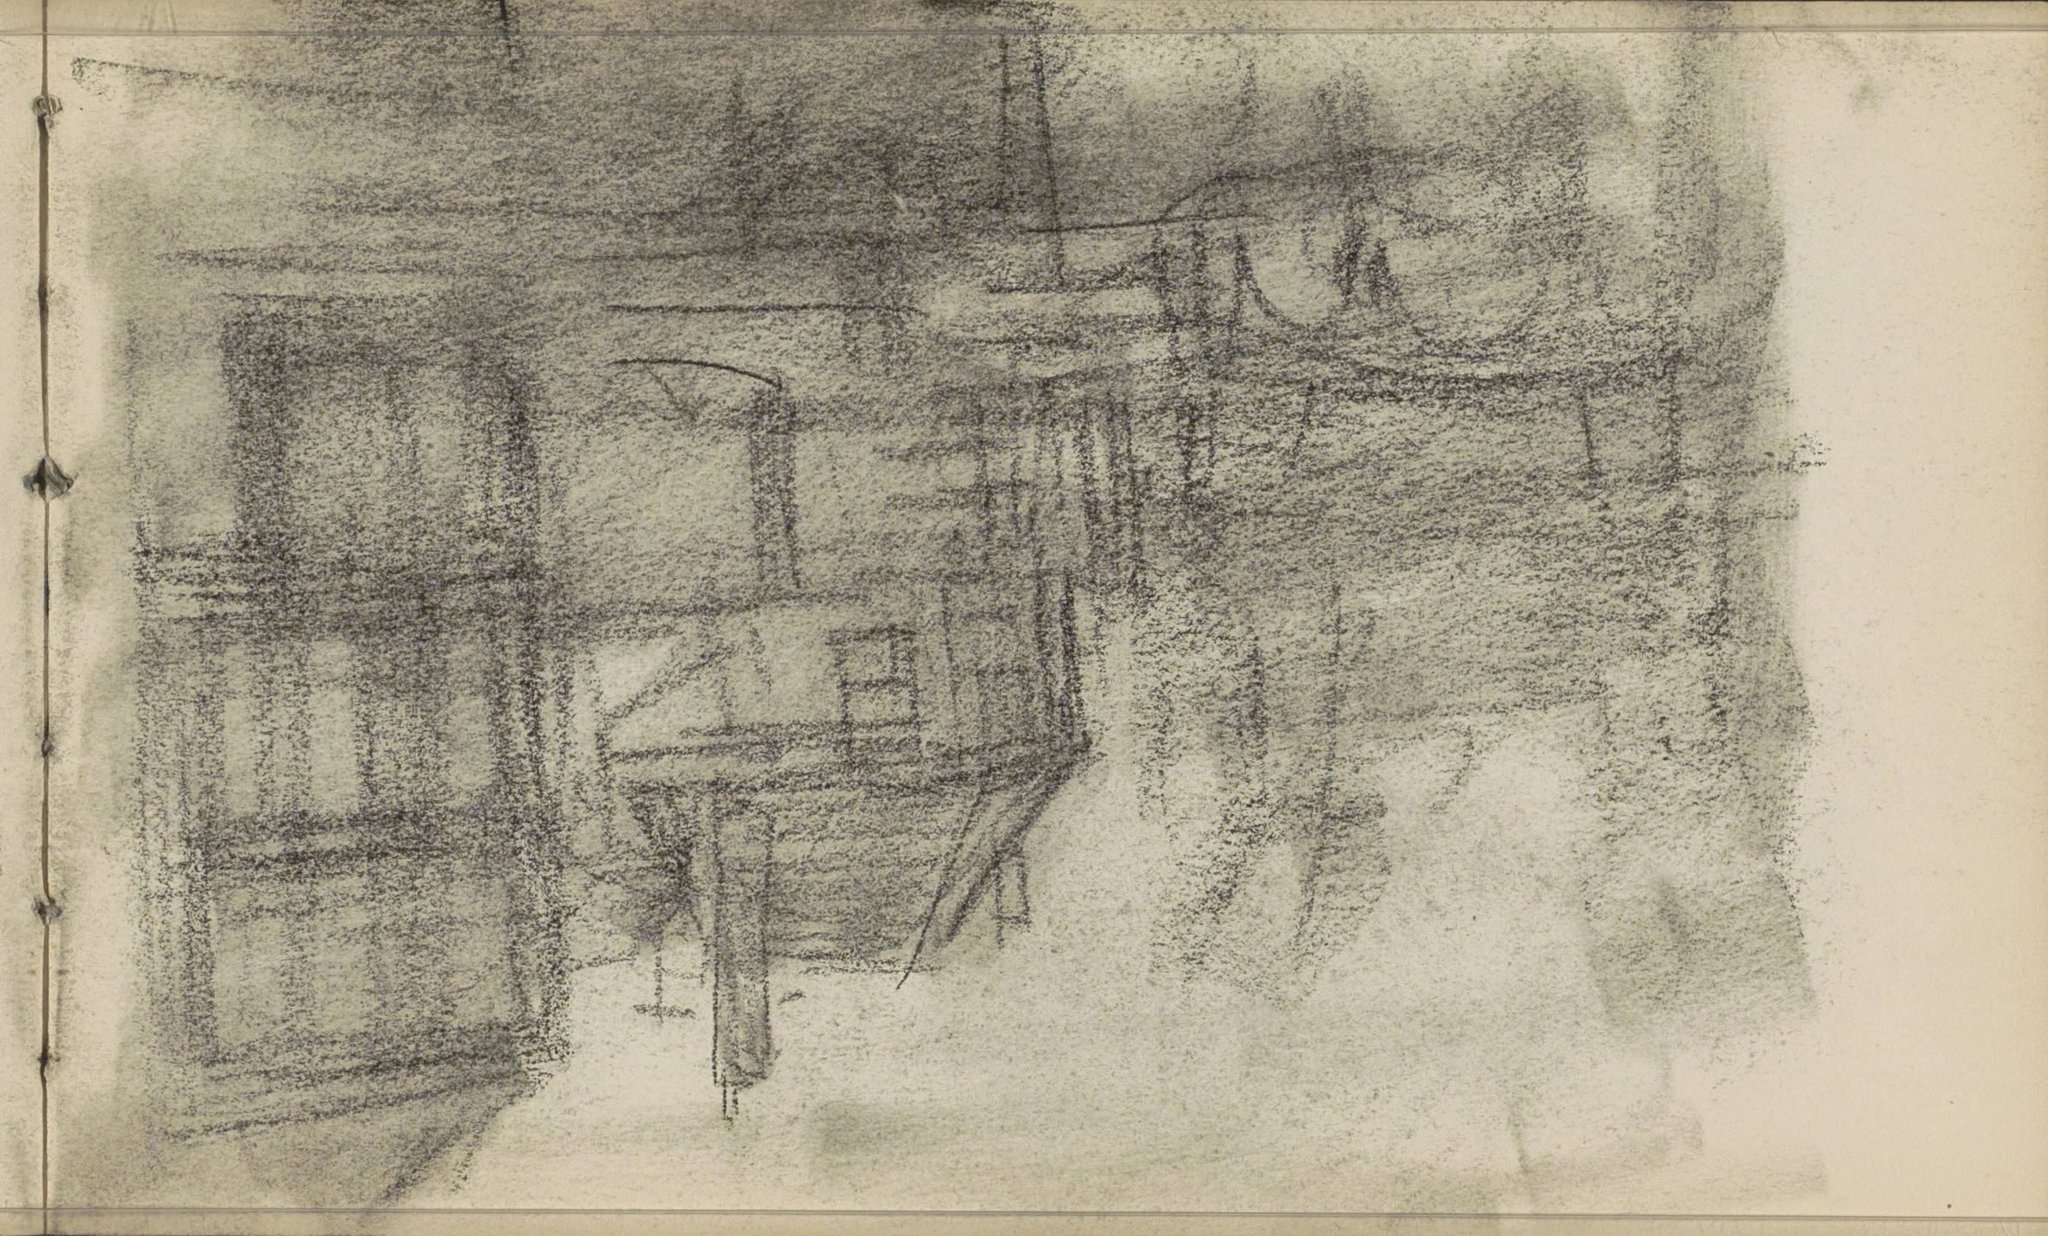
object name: sketchbook leaf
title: Stadsgezicht met een brug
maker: johan antonie de jonge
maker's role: draughtsman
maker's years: 1864-1927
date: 1901-1927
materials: chalk, paper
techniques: stumping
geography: south holland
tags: bridge in city across river, canal, etc.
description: Stadsgezicht met een brug over een gracht. Blad 30 recto uit een schetsboek met 45 bladen.